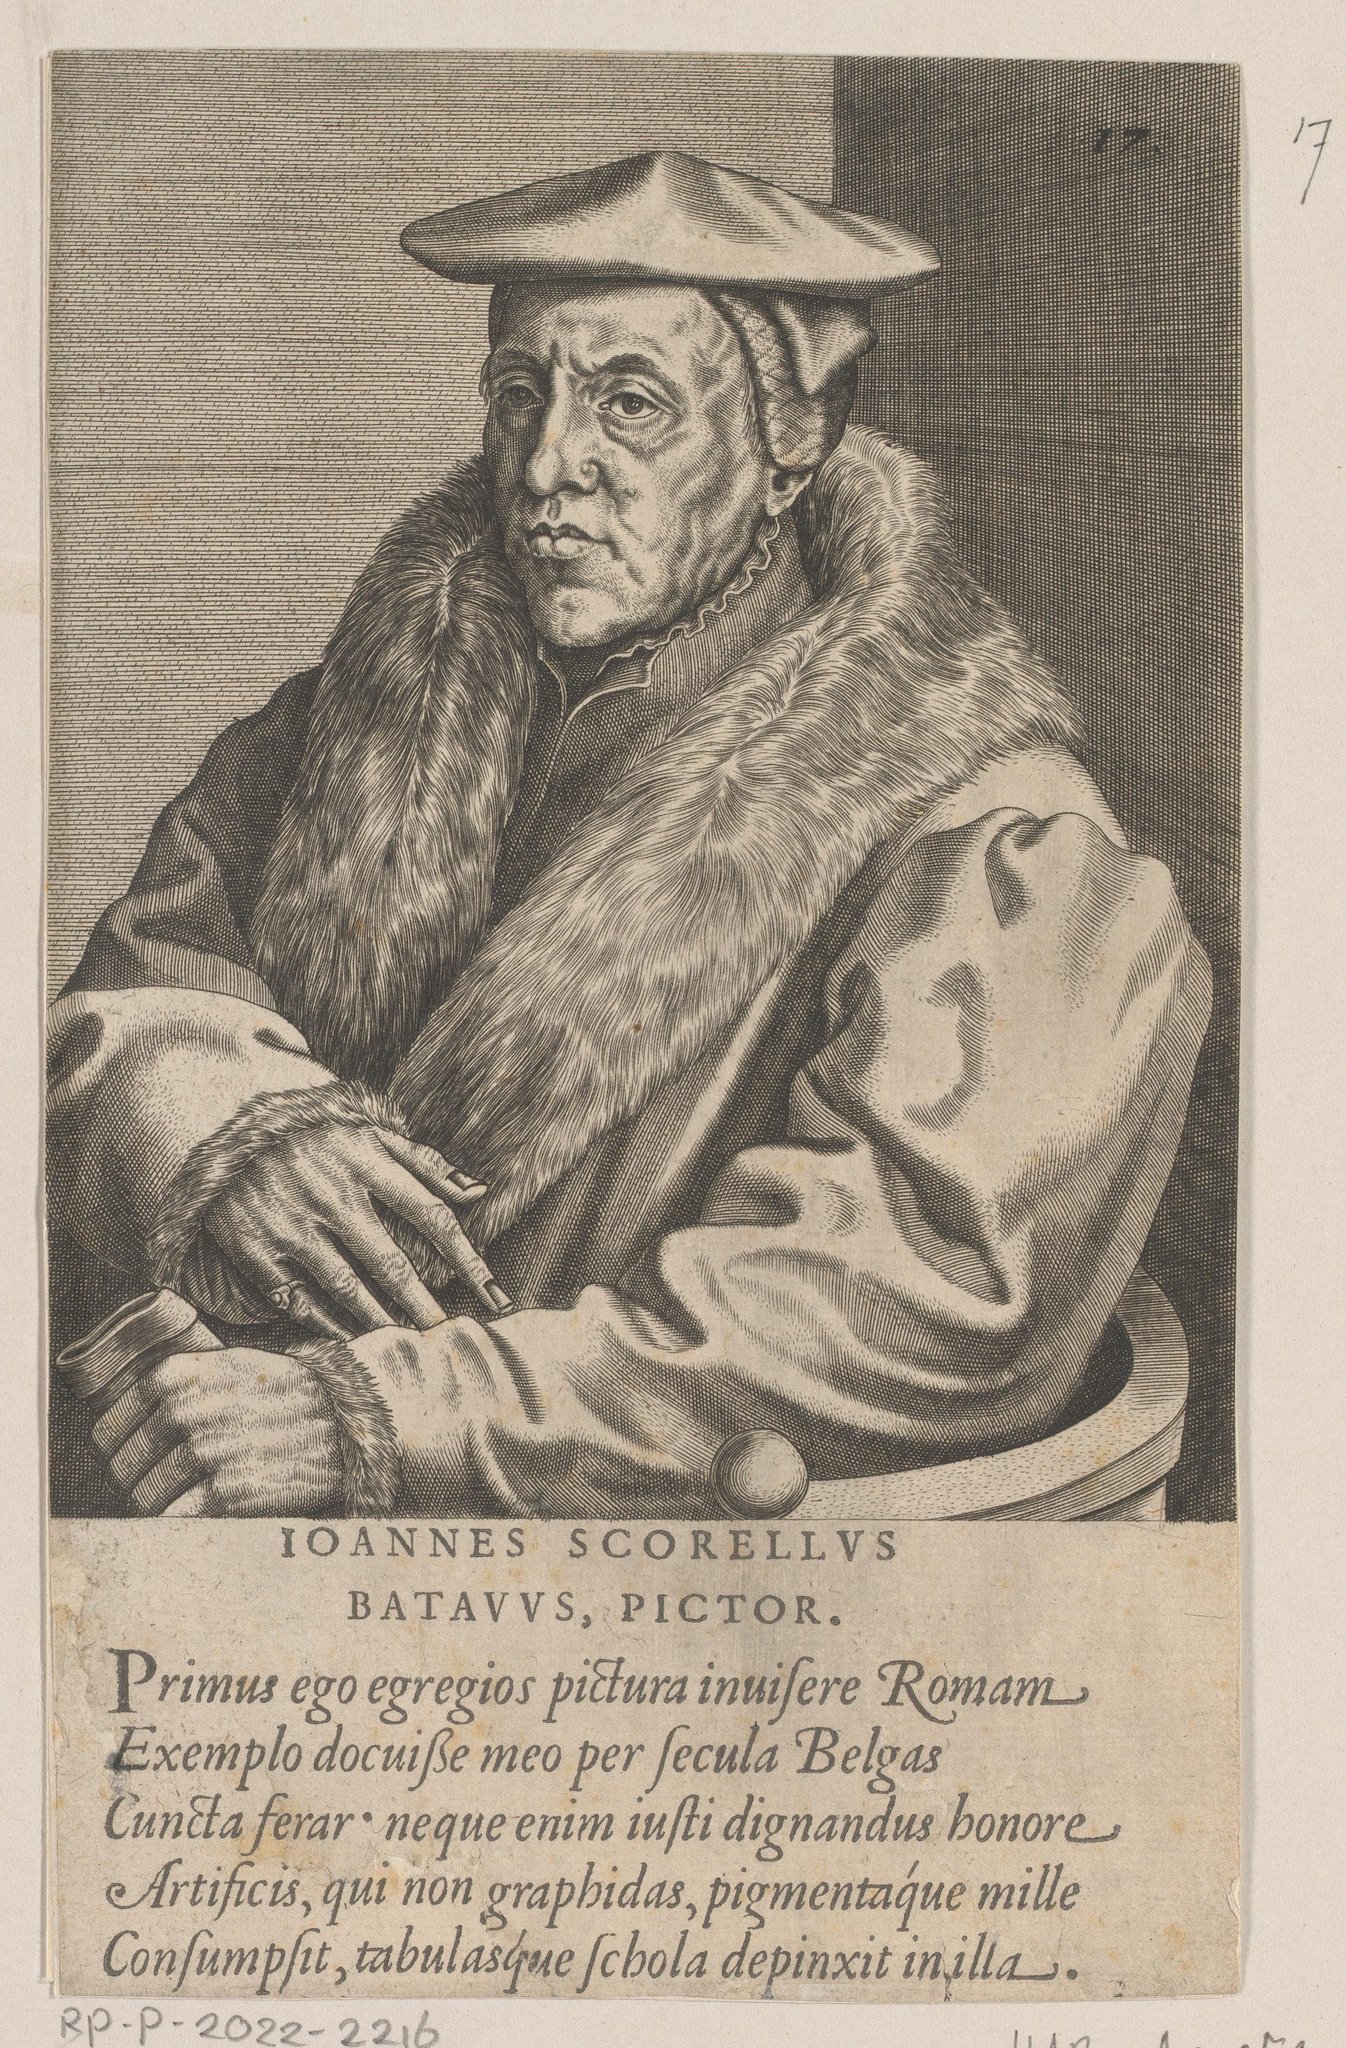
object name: print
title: Portret van Jan van Scorel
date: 1572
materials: paper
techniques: engraving, letterpress printing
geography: antwerp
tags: utrecht, painter, print maker, draughtsman, jan van scorel, historical persons, portrait, self-portrait of artist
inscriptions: collector's mark: Lugt 2165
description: Prent waarschijnlijk uit: Cock, Hieronymus en Dominicus Lampsonius. Pictorum aliquot celebrium Germaniae inferioris effigies (...). Antwerpen: weduwe Hieronymus Cock, 1572.